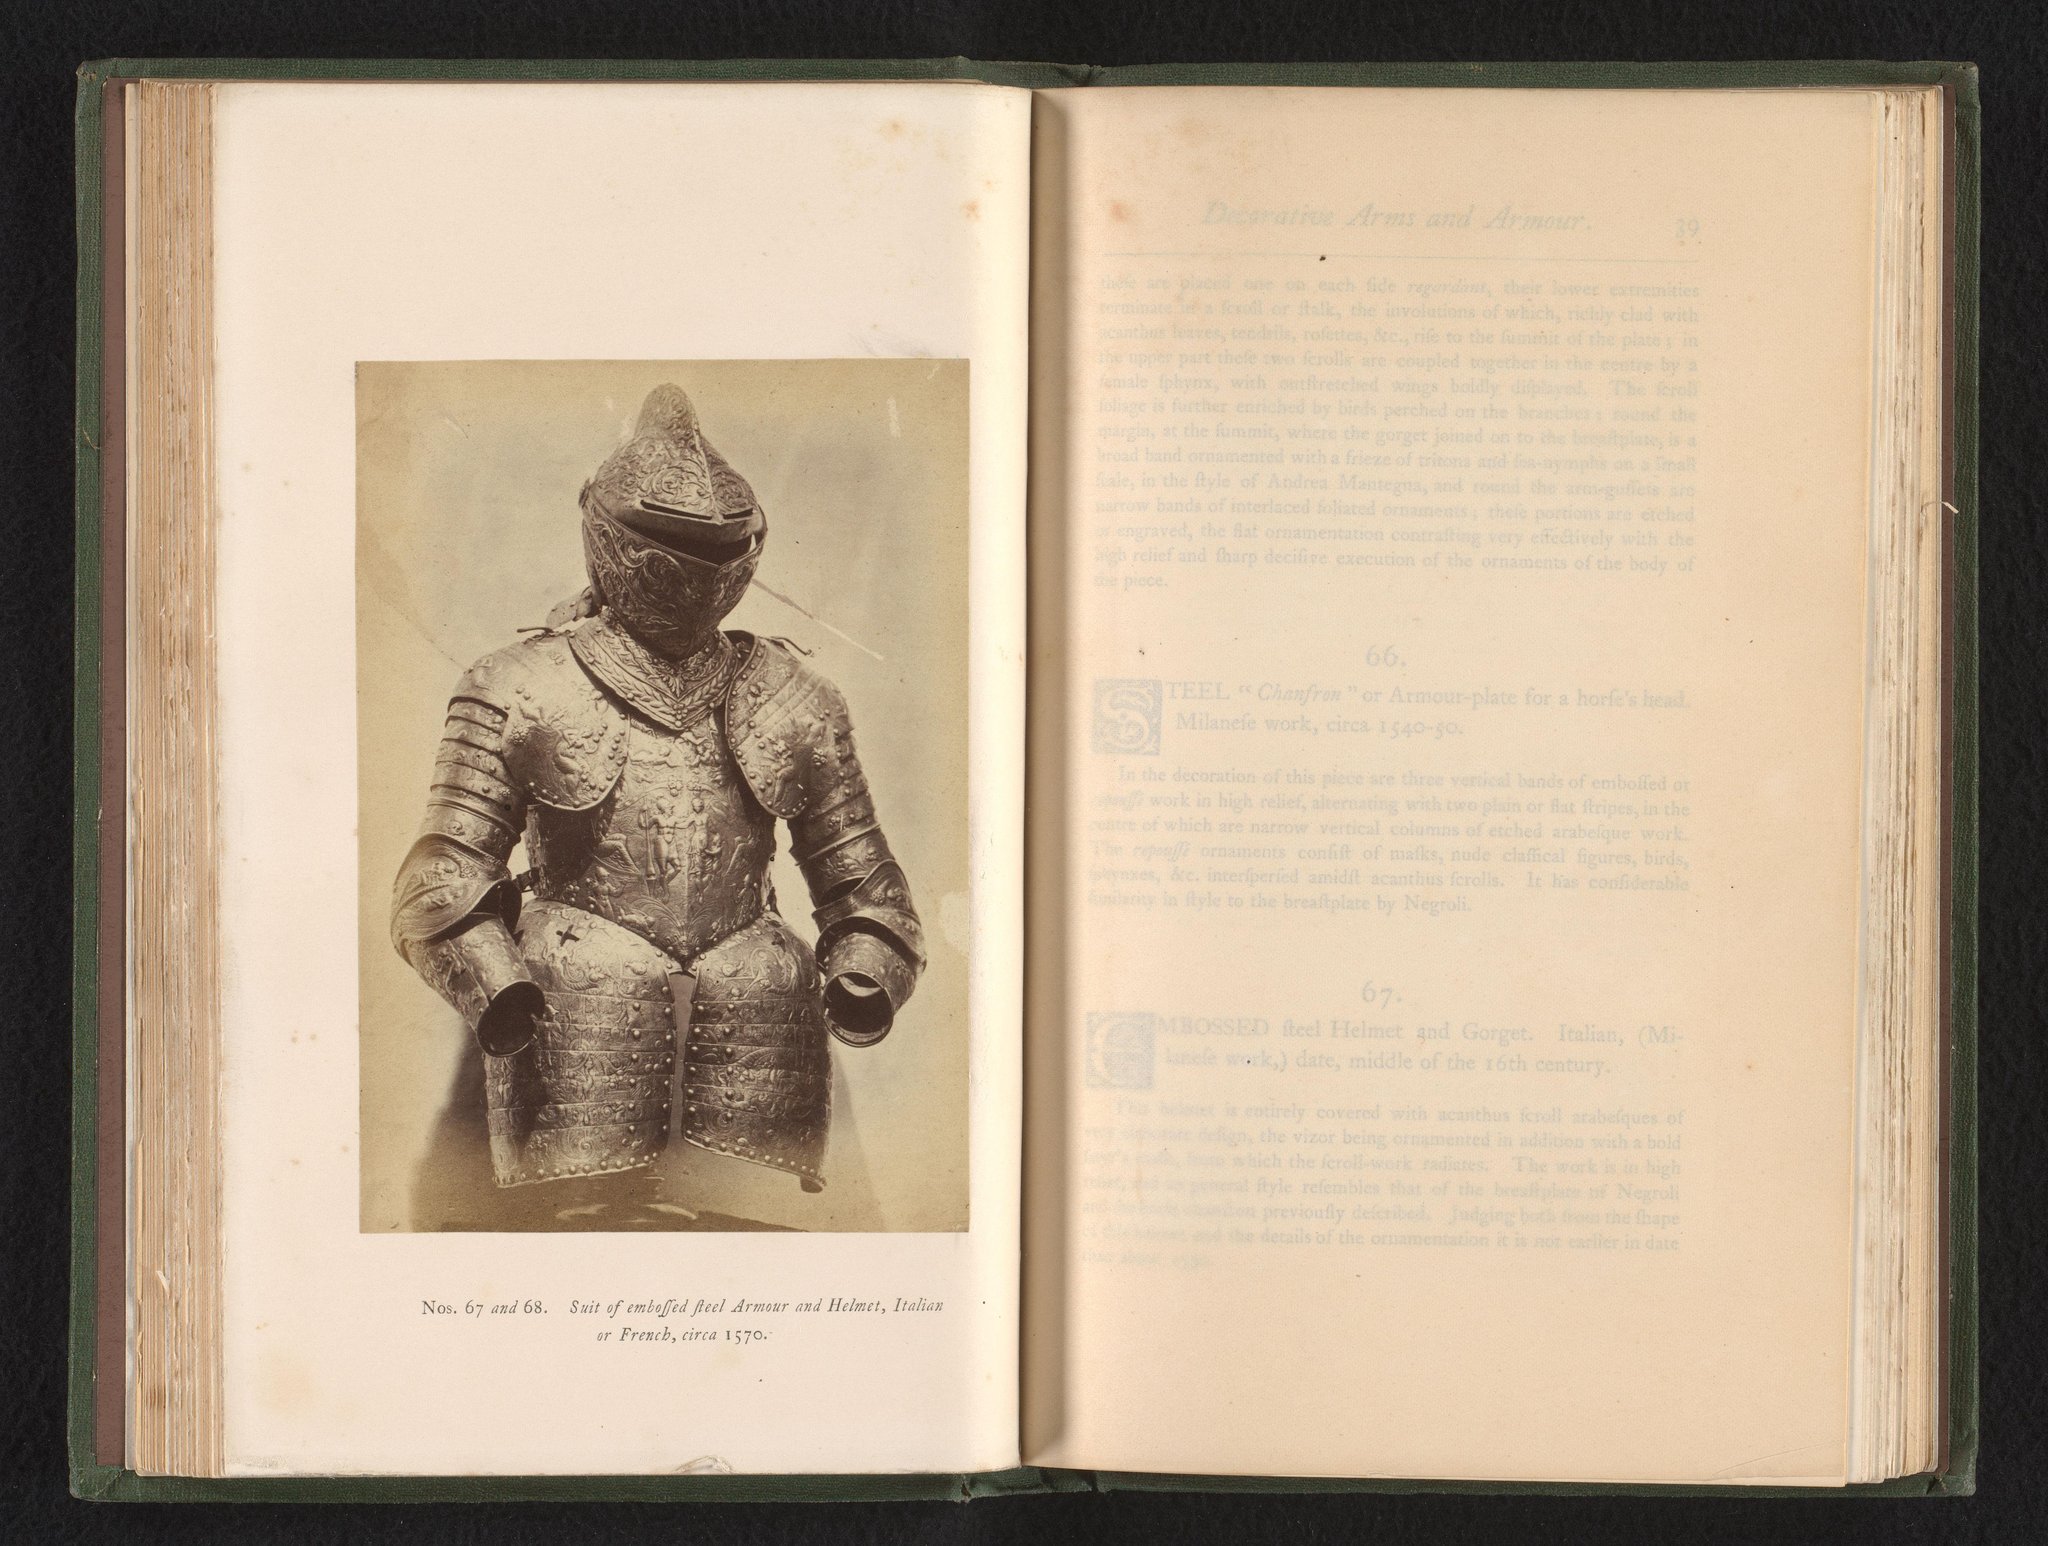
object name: page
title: Suit of embossed steel Armour and Helmet, Italian or French circa 1570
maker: Anonymous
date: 1851-1861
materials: paper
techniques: albumen print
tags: armour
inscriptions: number: ‘Nos. 67 en 68.’